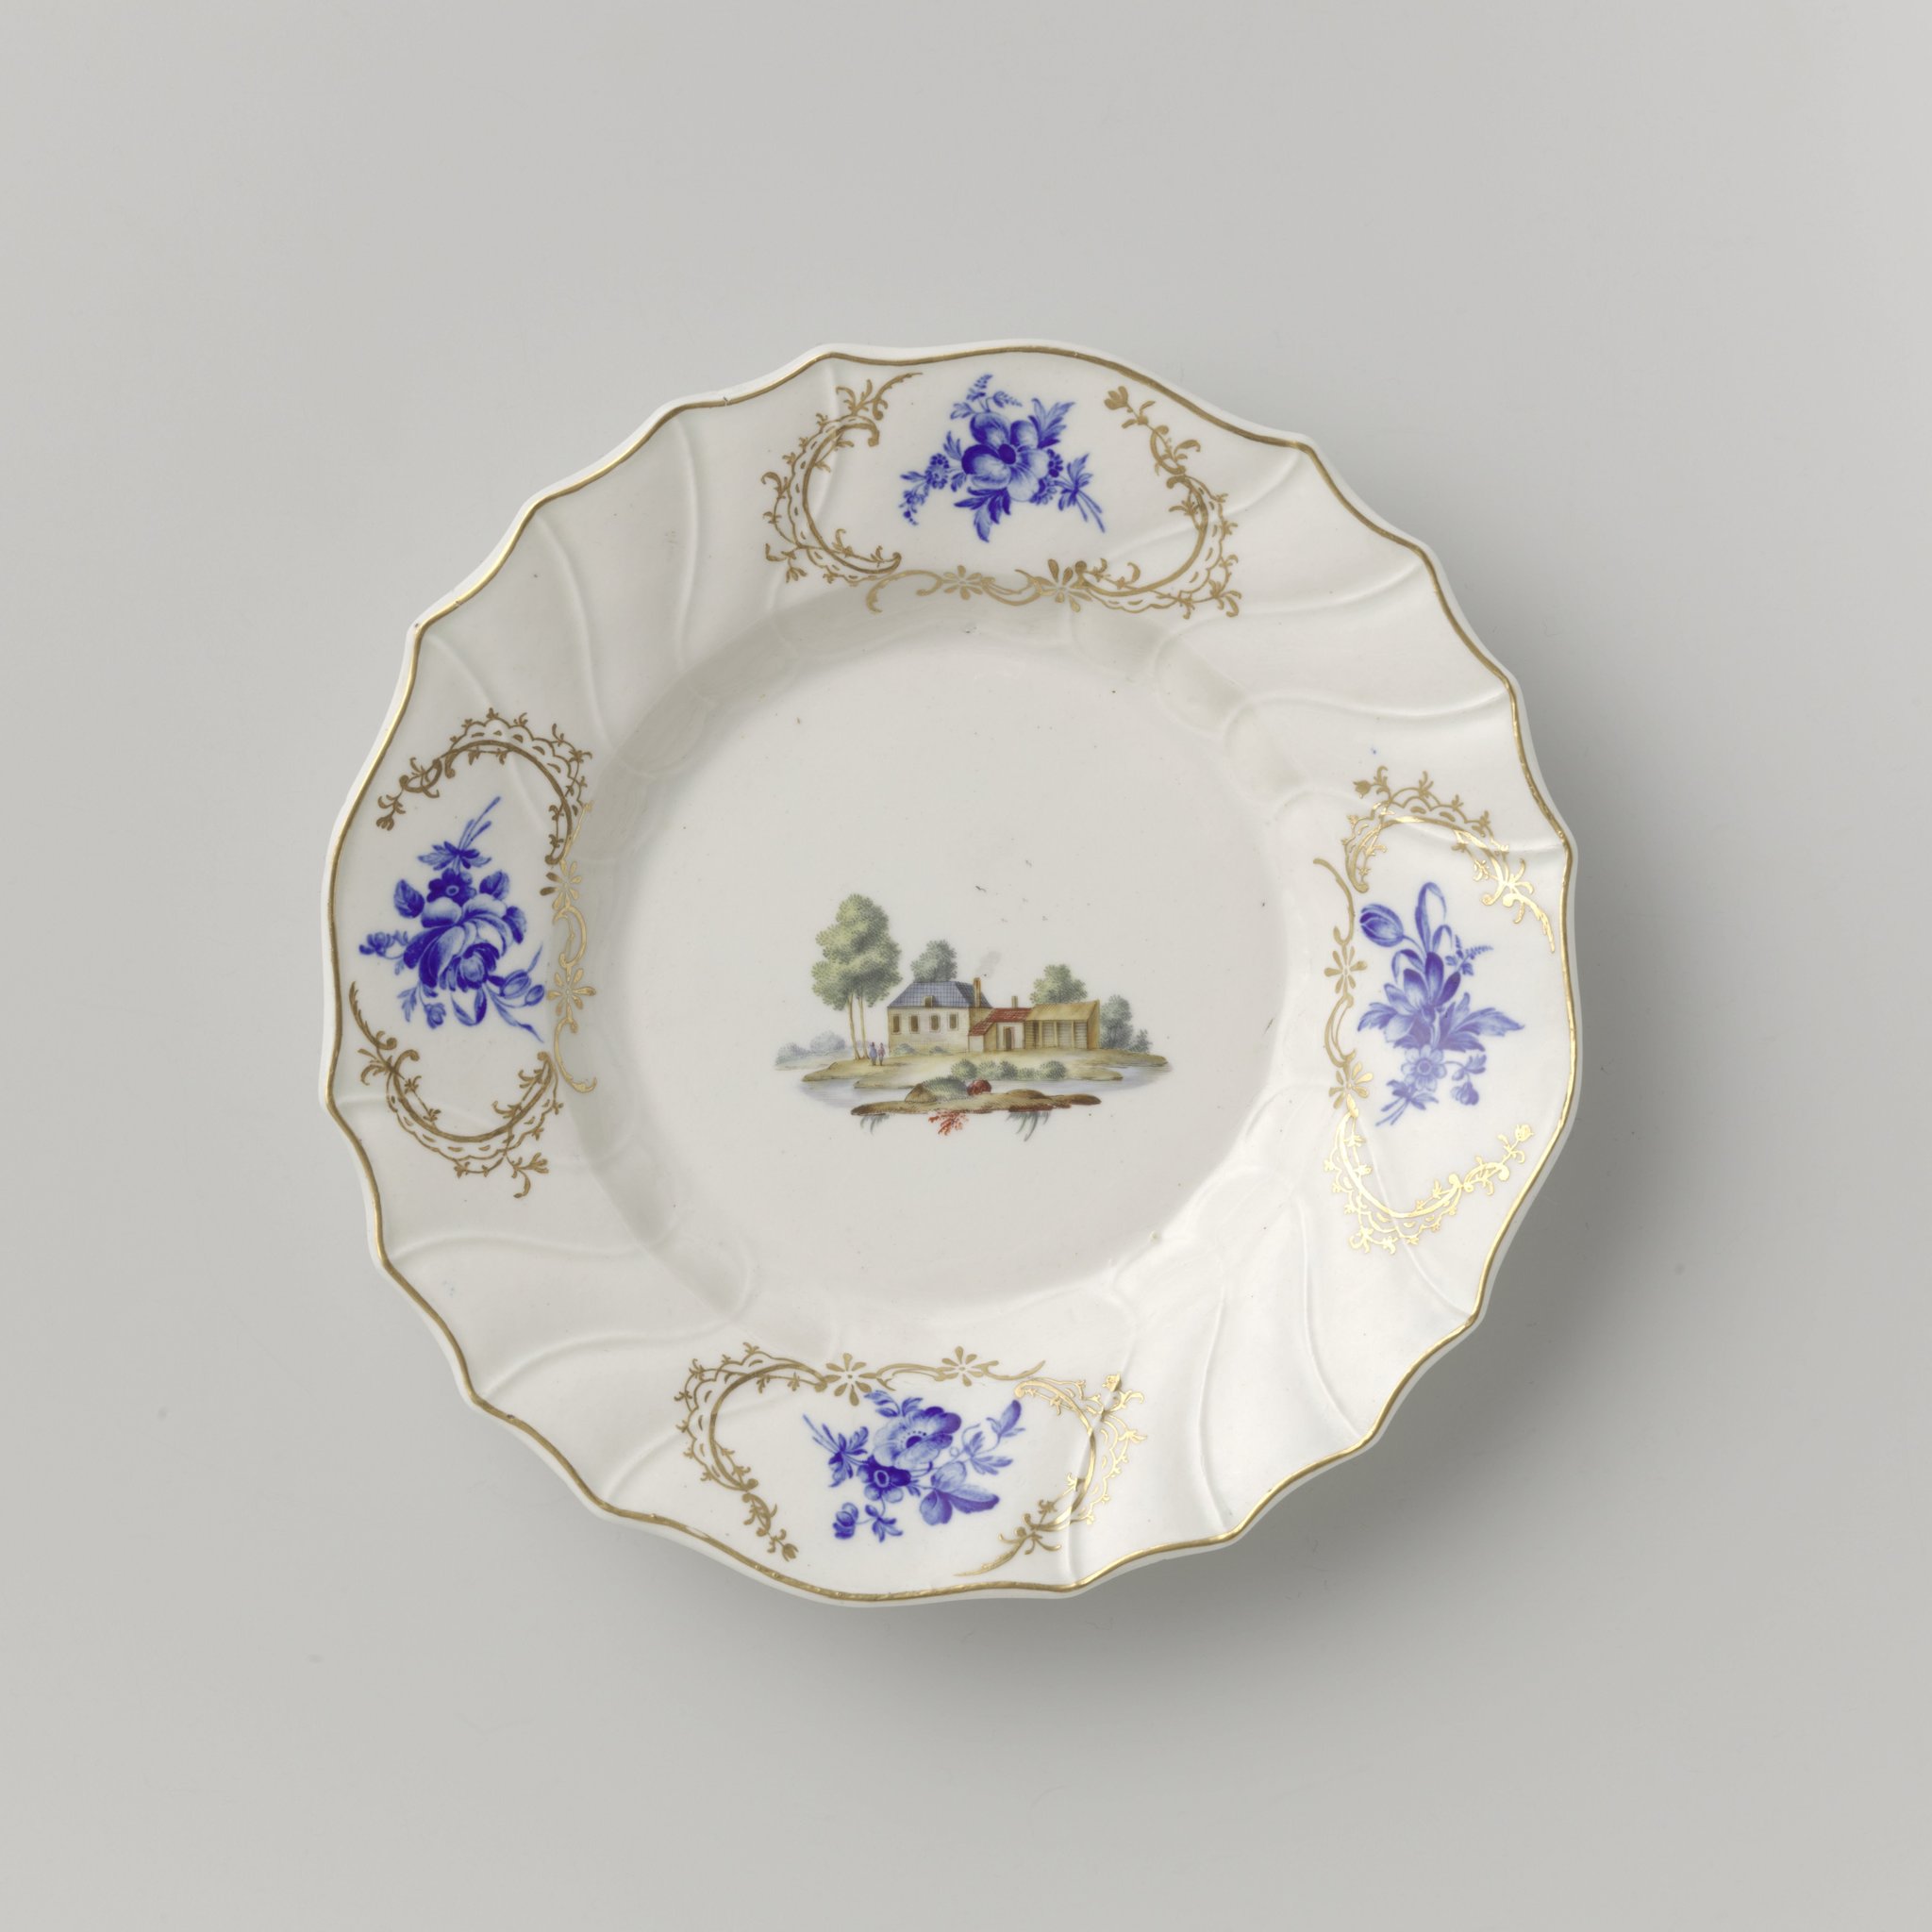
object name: platter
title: Dish of a butter tub with a cityscape and bouquets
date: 1778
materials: glaze, gold, paint, porcelain, soft paste porcelain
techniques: firing, forming, gilding, turning, vitrification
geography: doornik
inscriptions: inscription: ‘MERDERVOORT’, mark: ‘ooievaar/ g’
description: Schotel van een botervloot van soft-paste porselein (pâte tendre) met een geschulpte rand, beschilderd op het glazuur in emailkleuren en goud. Op het plat een stadsgezicht op Merdervoort. De rand, doorlopend op de wand, is licht gemodelleerd in telkens drie smalle en één breed getordeerd vak. In de vier brede vakken een rocaille cartouche met daarin boeketten. Gouden rand. Gemerkt op de onderzijde met de ooievaar, 'MEDERVOORT' en g.